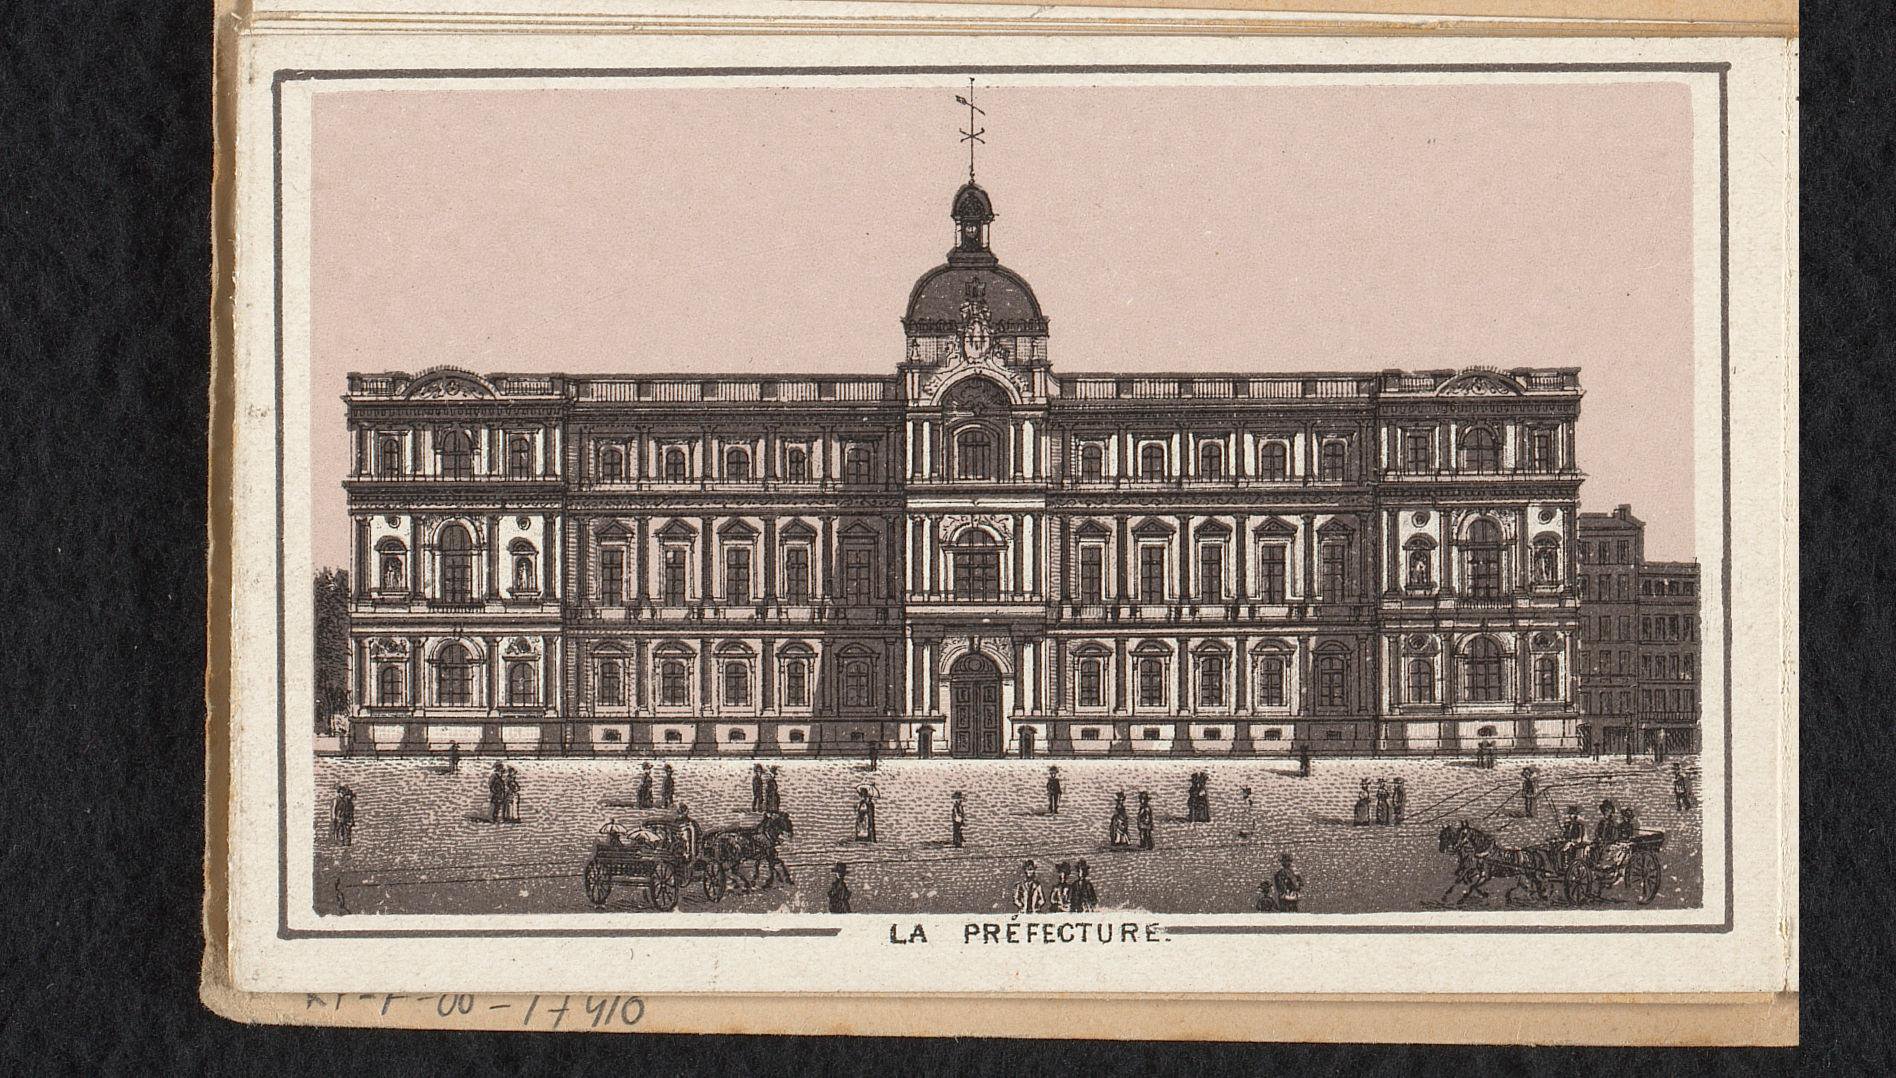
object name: print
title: La Préfecture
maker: Anonymous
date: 1890-1910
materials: cardboard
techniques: lithograph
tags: administrative bodies, civic architecture; edifices; dwellings, square, place, circus, etc. (+ city(-scape) with figures, staffage), marseille